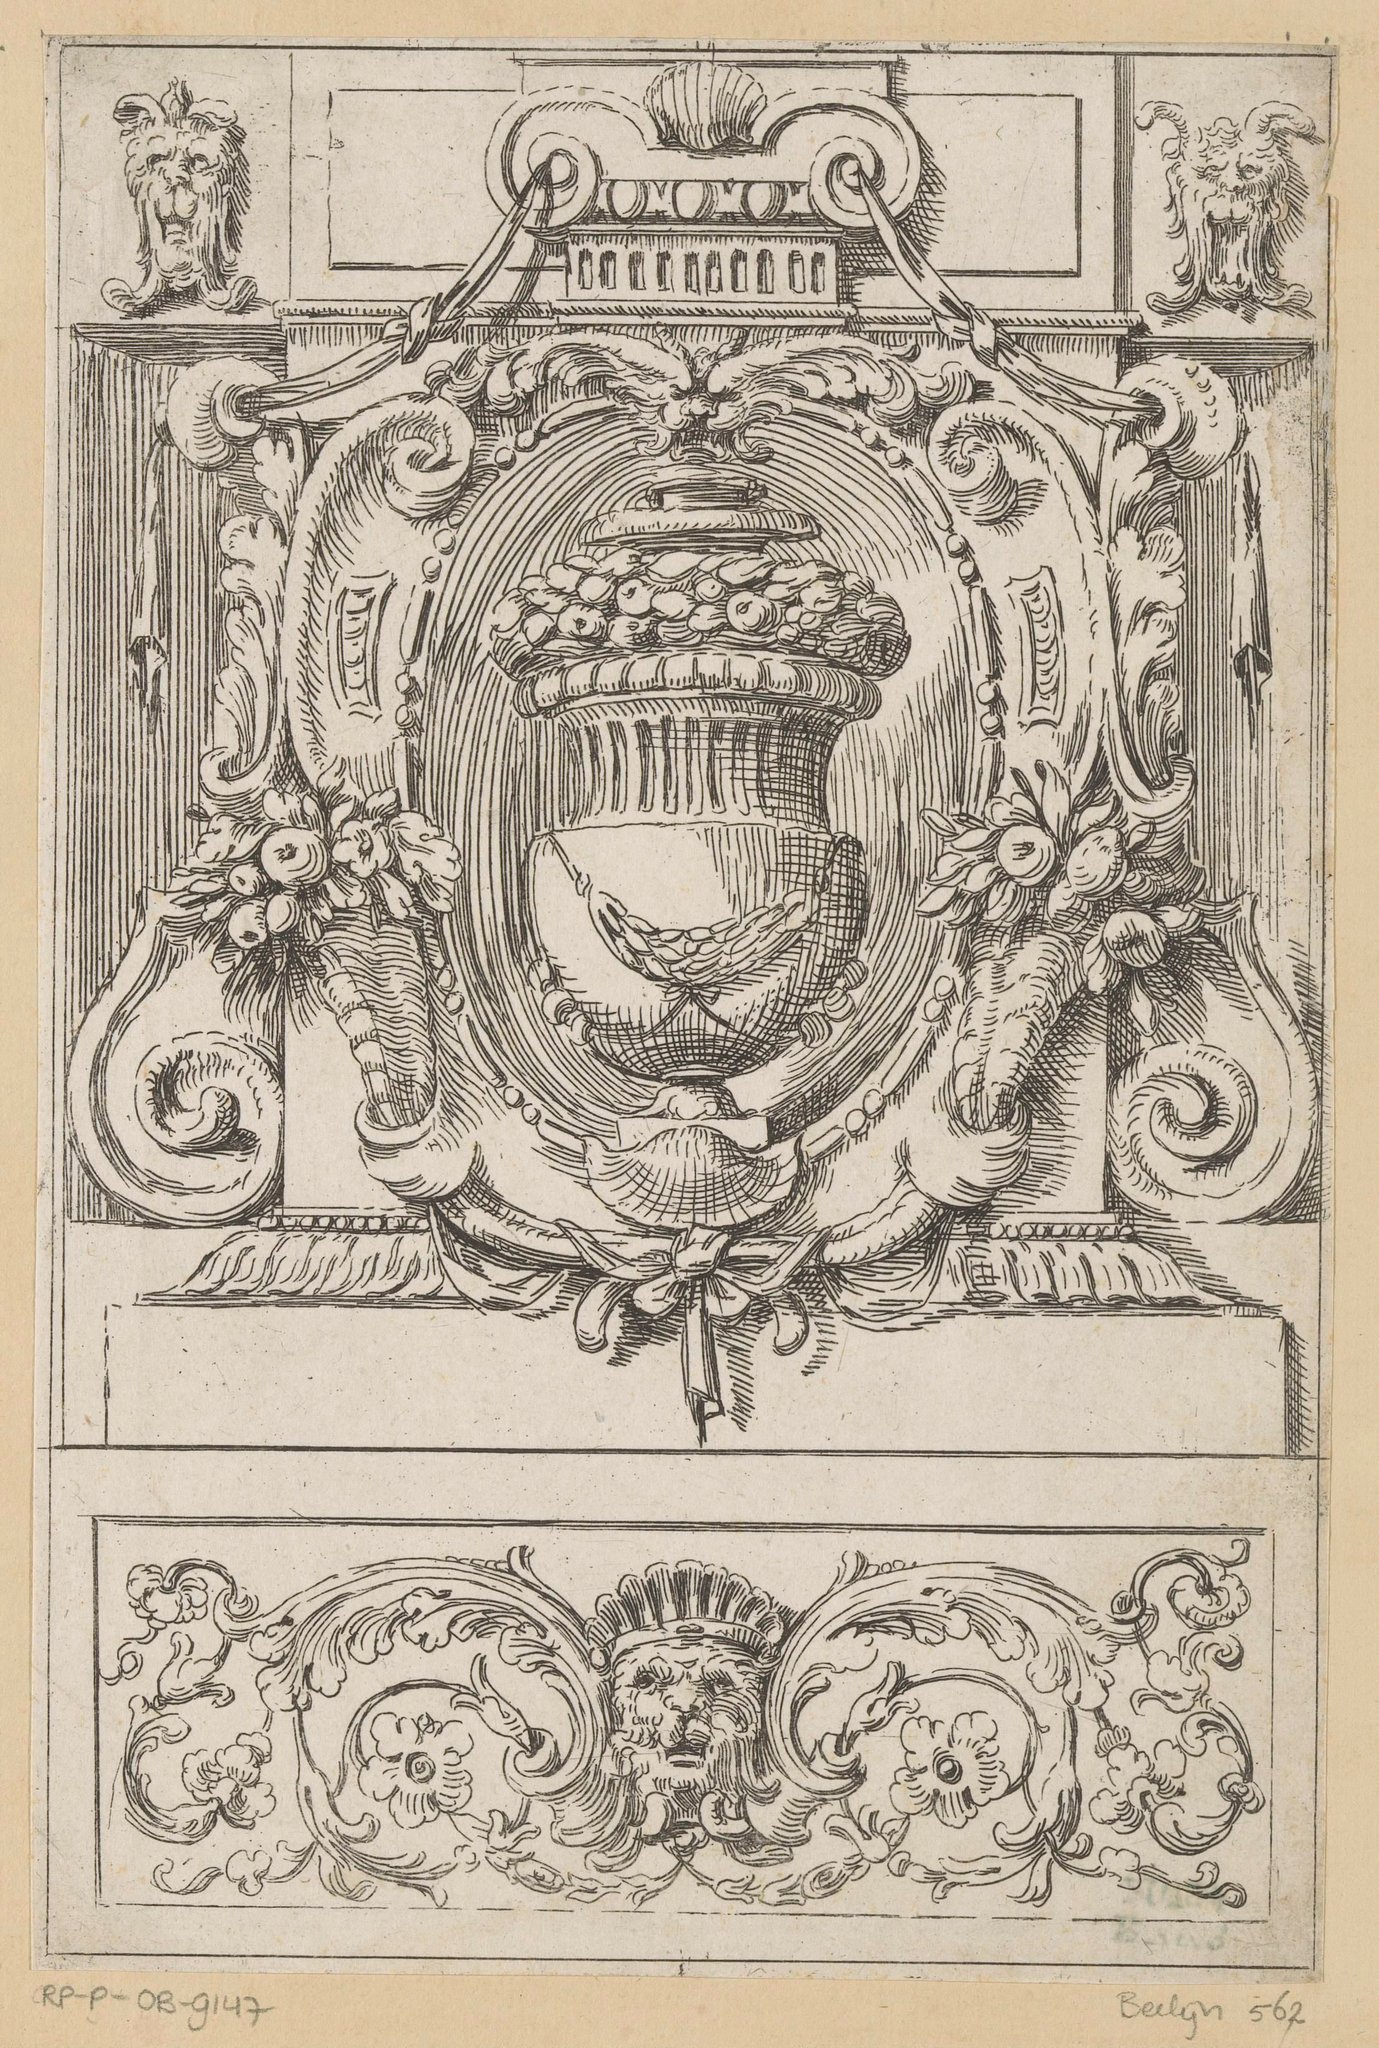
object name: print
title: Cartouches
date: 1636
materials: paper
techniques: etching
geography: italy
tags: foliage ~ ornament, vase ~ ornament, ornament ~ cartouche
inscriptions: collector's mark: Lugt 2165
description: Deze prent maakt deel uit van een reeks van 22 prenten met in totaal 24 cartouches, plus een titelprent.